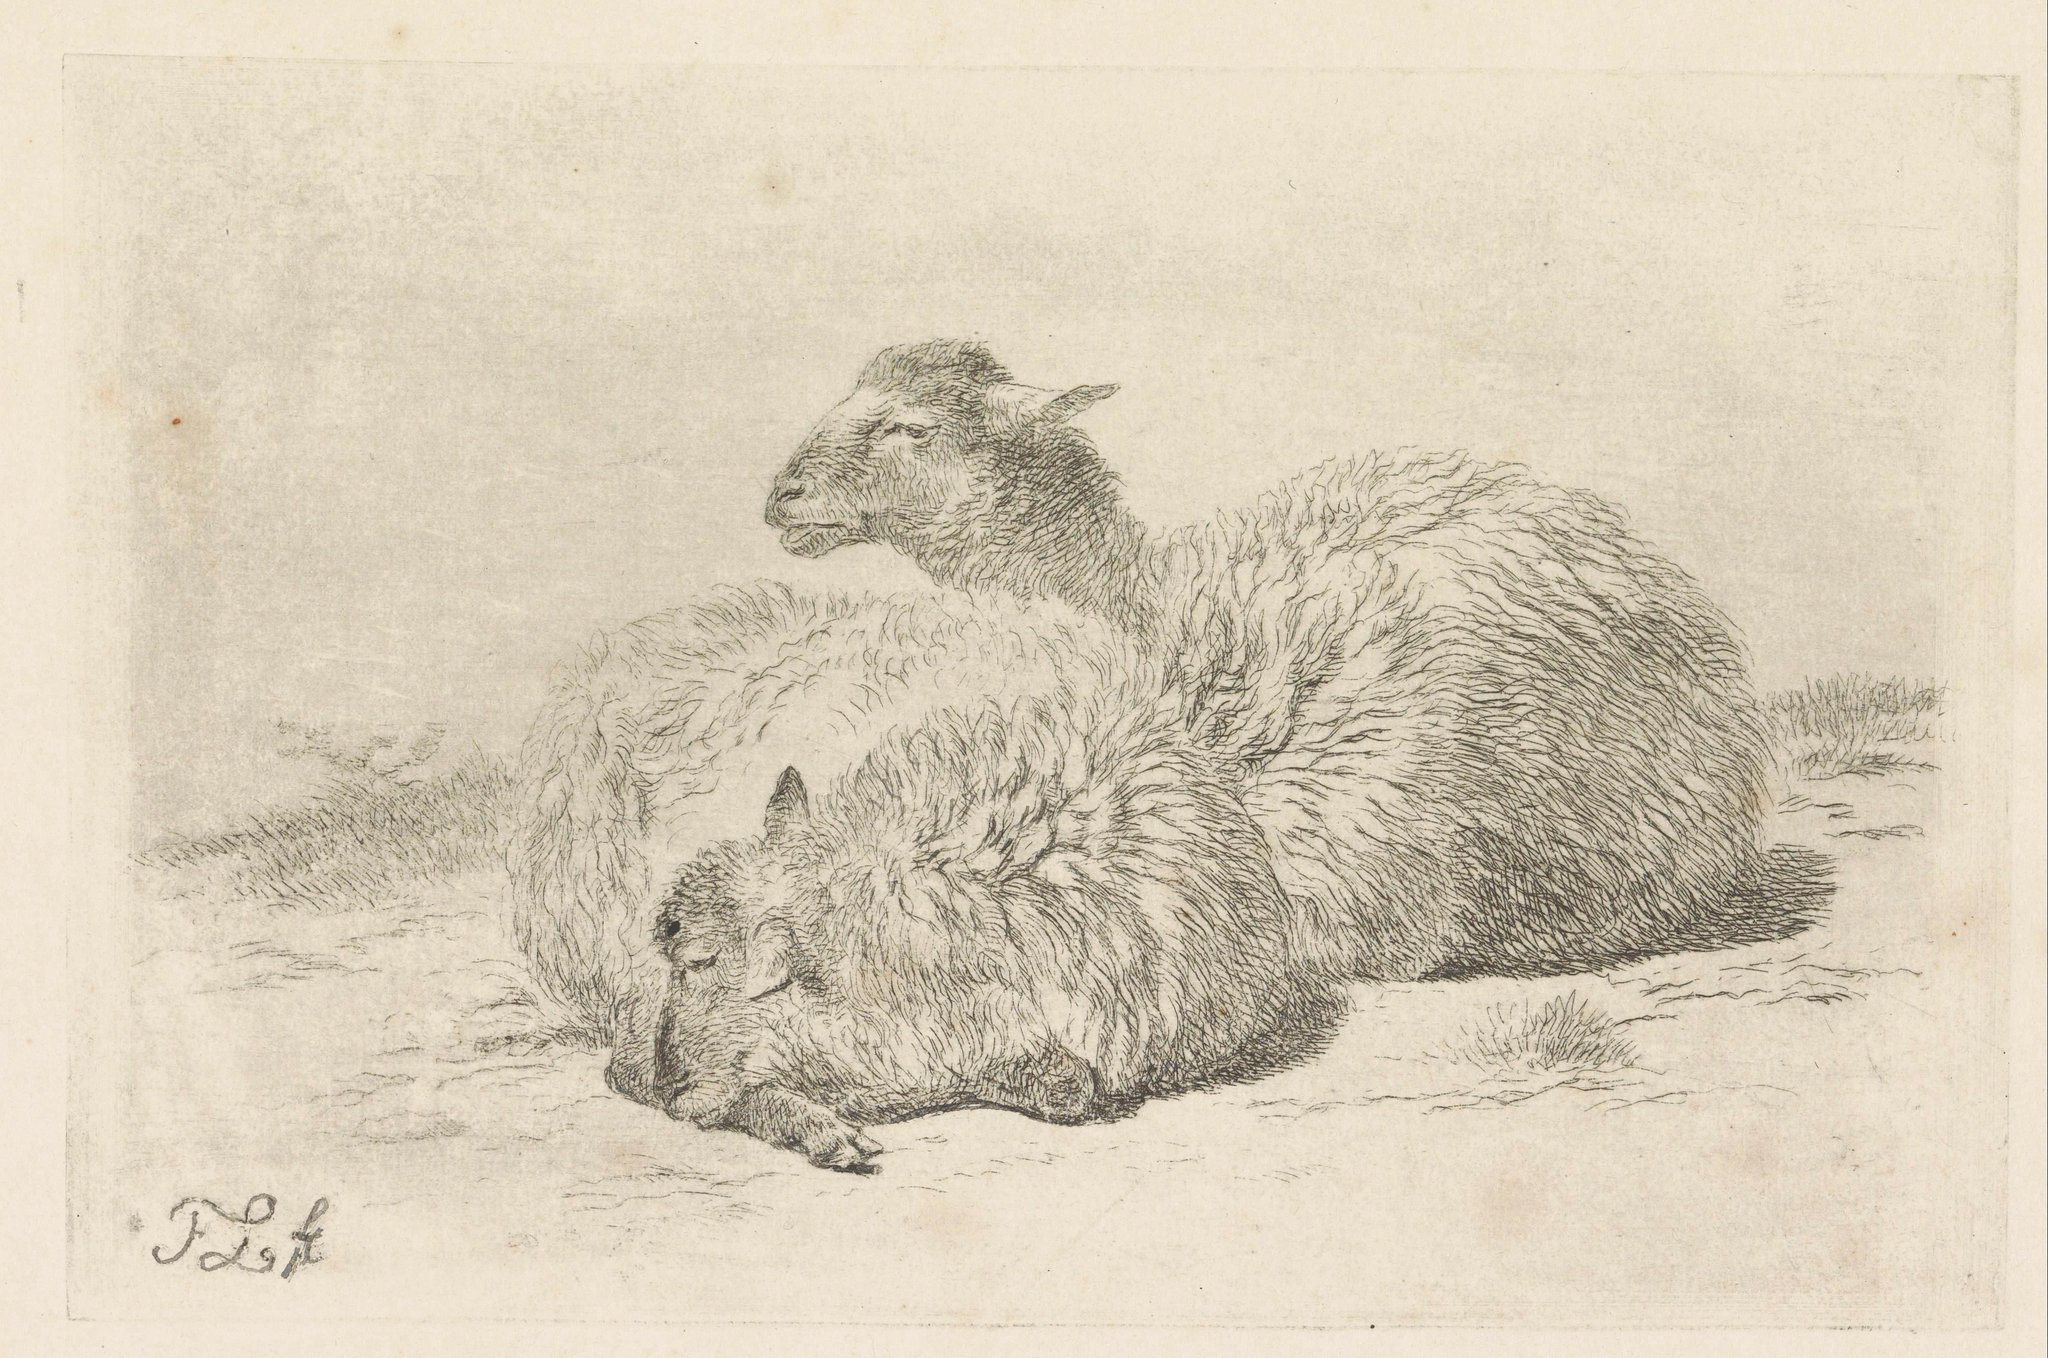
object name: print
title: Twee liggende schapen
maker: frans lebret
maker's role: draughtsman, painter, print maker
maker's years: 1820-1909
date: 1809-1820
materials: paper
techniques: etching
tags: sheep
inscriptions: collector's mark: Lugt 2228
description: Twee liggende schapen, schuin van voren en opzij gezien.